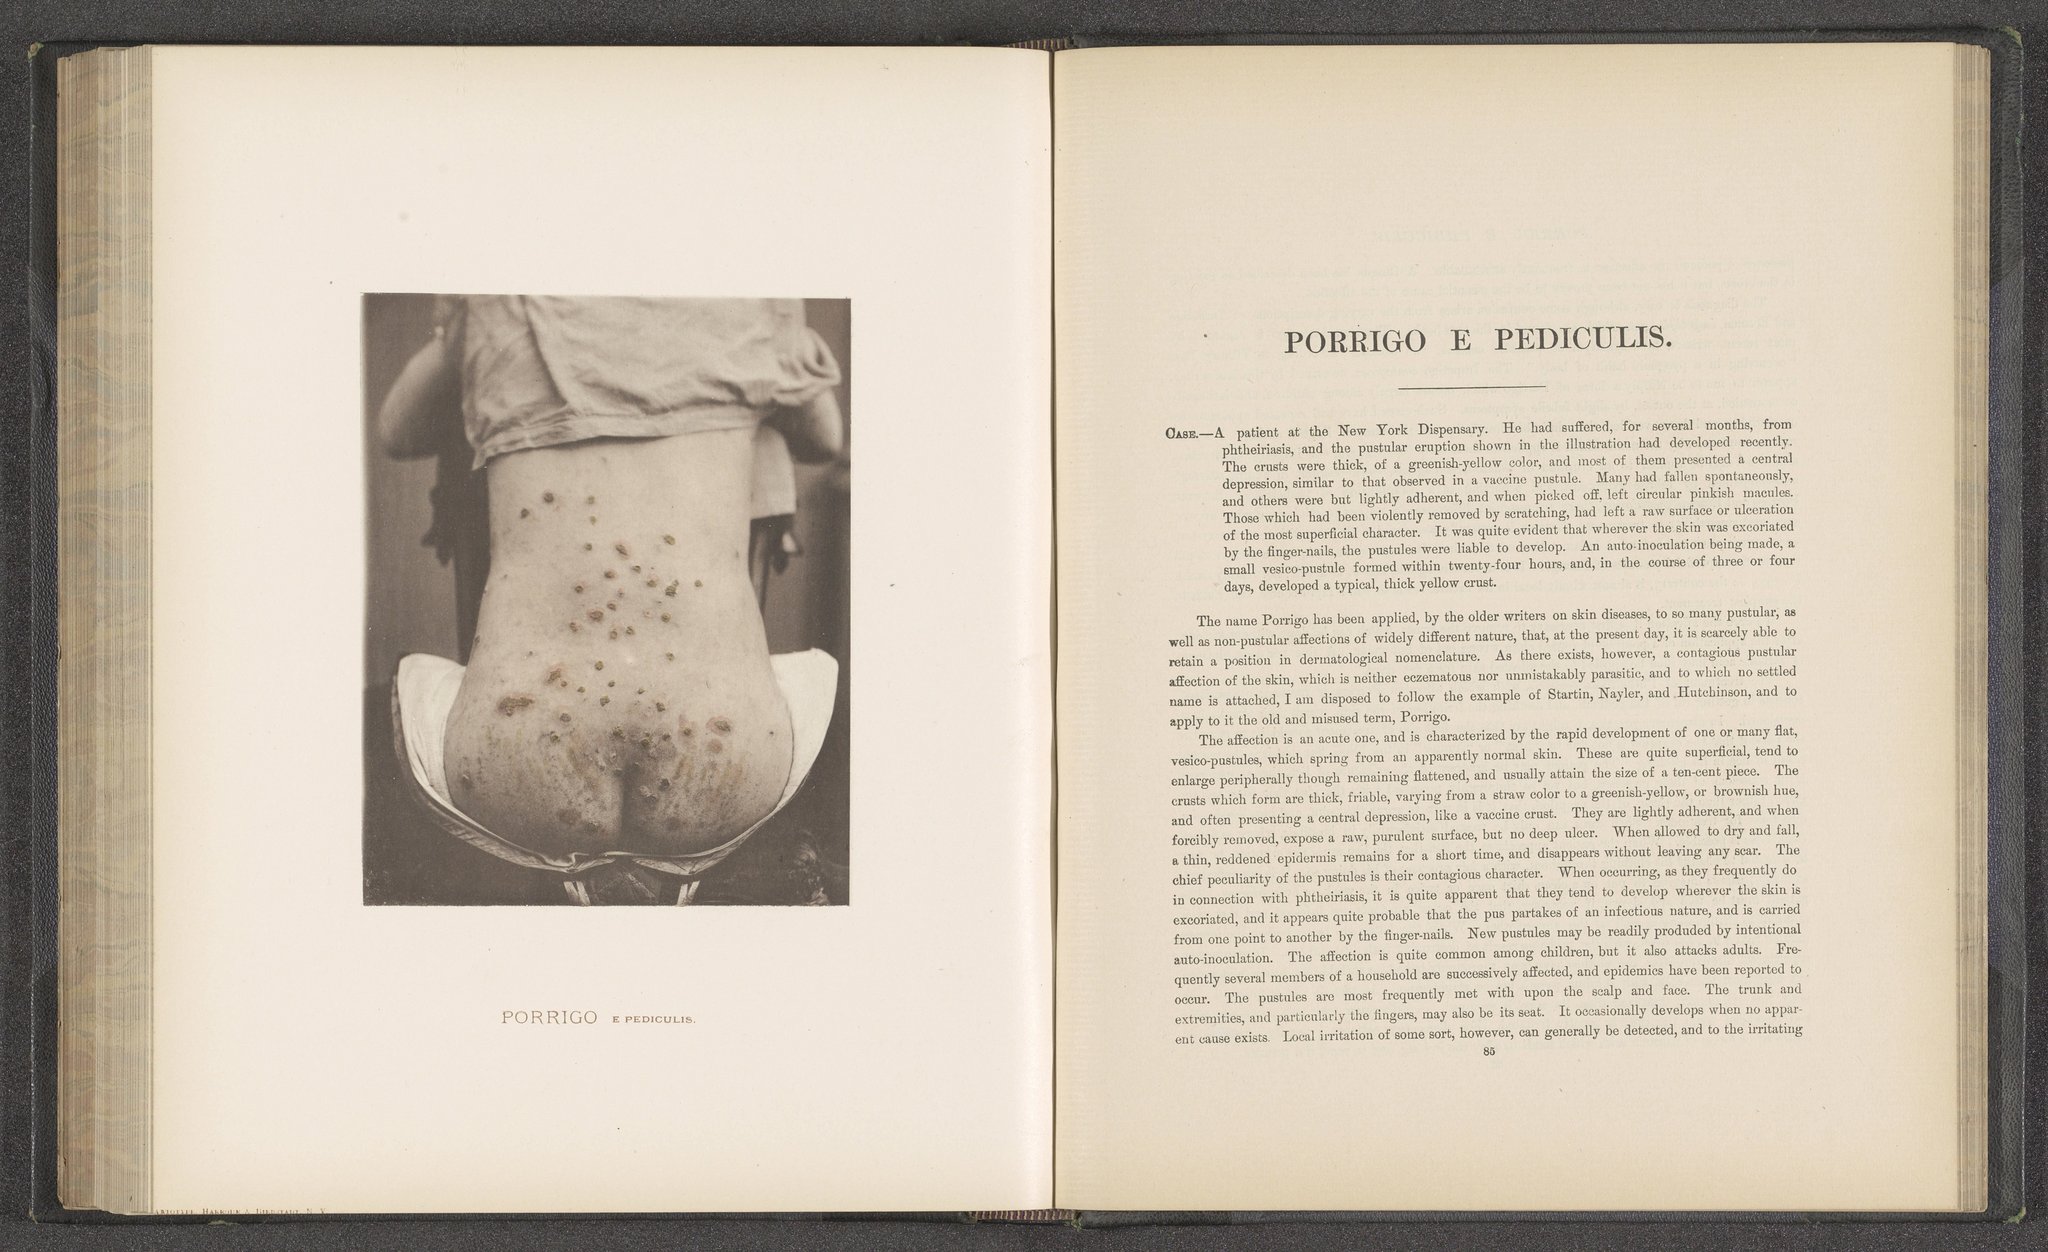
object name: page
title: Patiënt lijdend aan de huidziekte 'porrigo e pediculis'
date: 1870-1881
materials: paper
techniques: photograph, hand coloring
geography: new york city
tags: skin and venereal diseases, child, back, buttocks, 'partes posteriores'